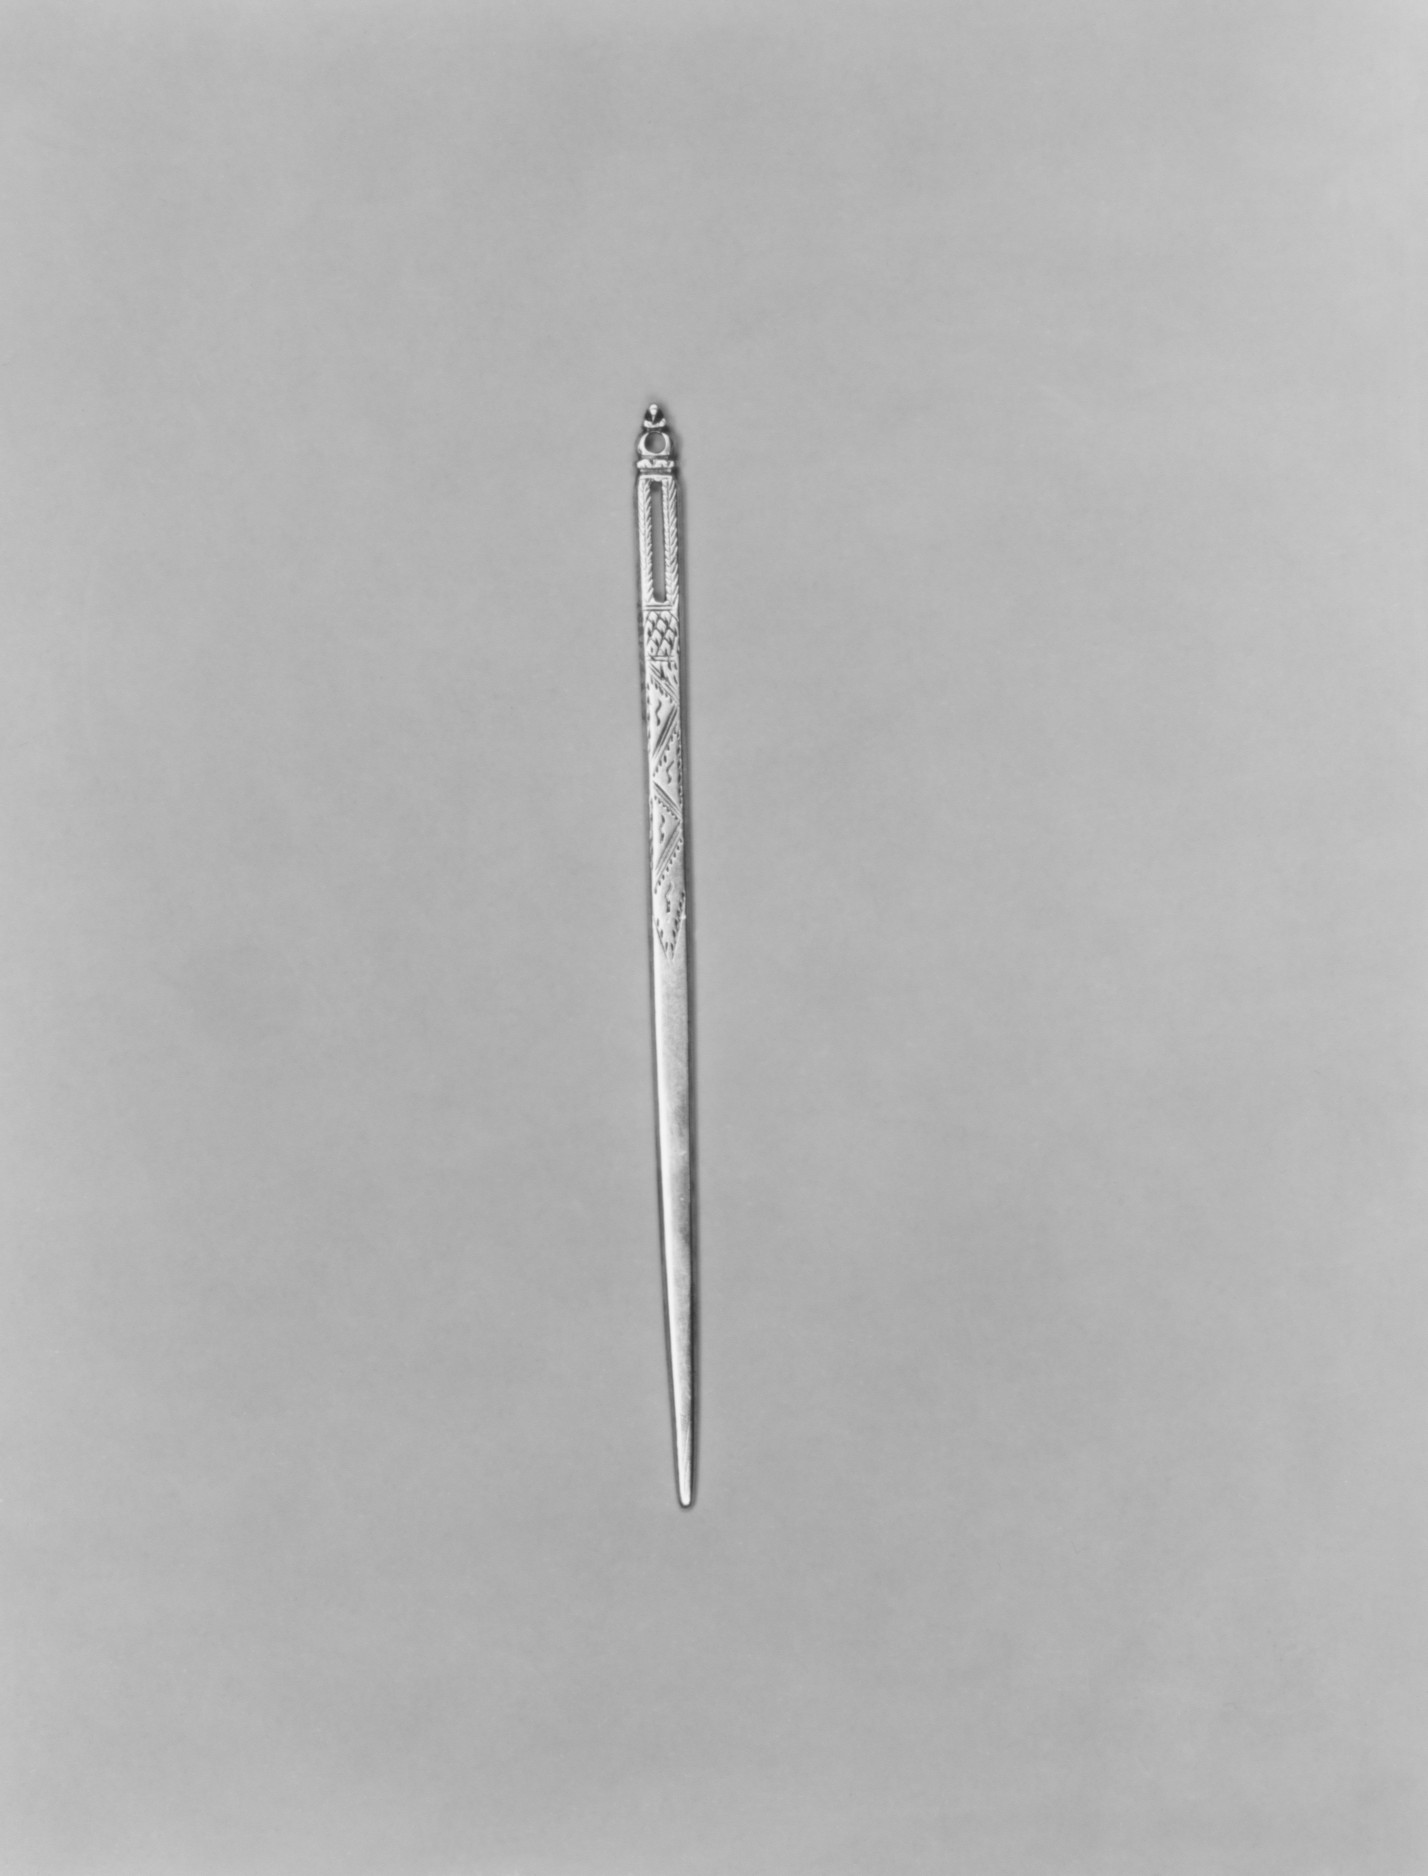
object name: bodkin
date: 1620-1640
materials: silver